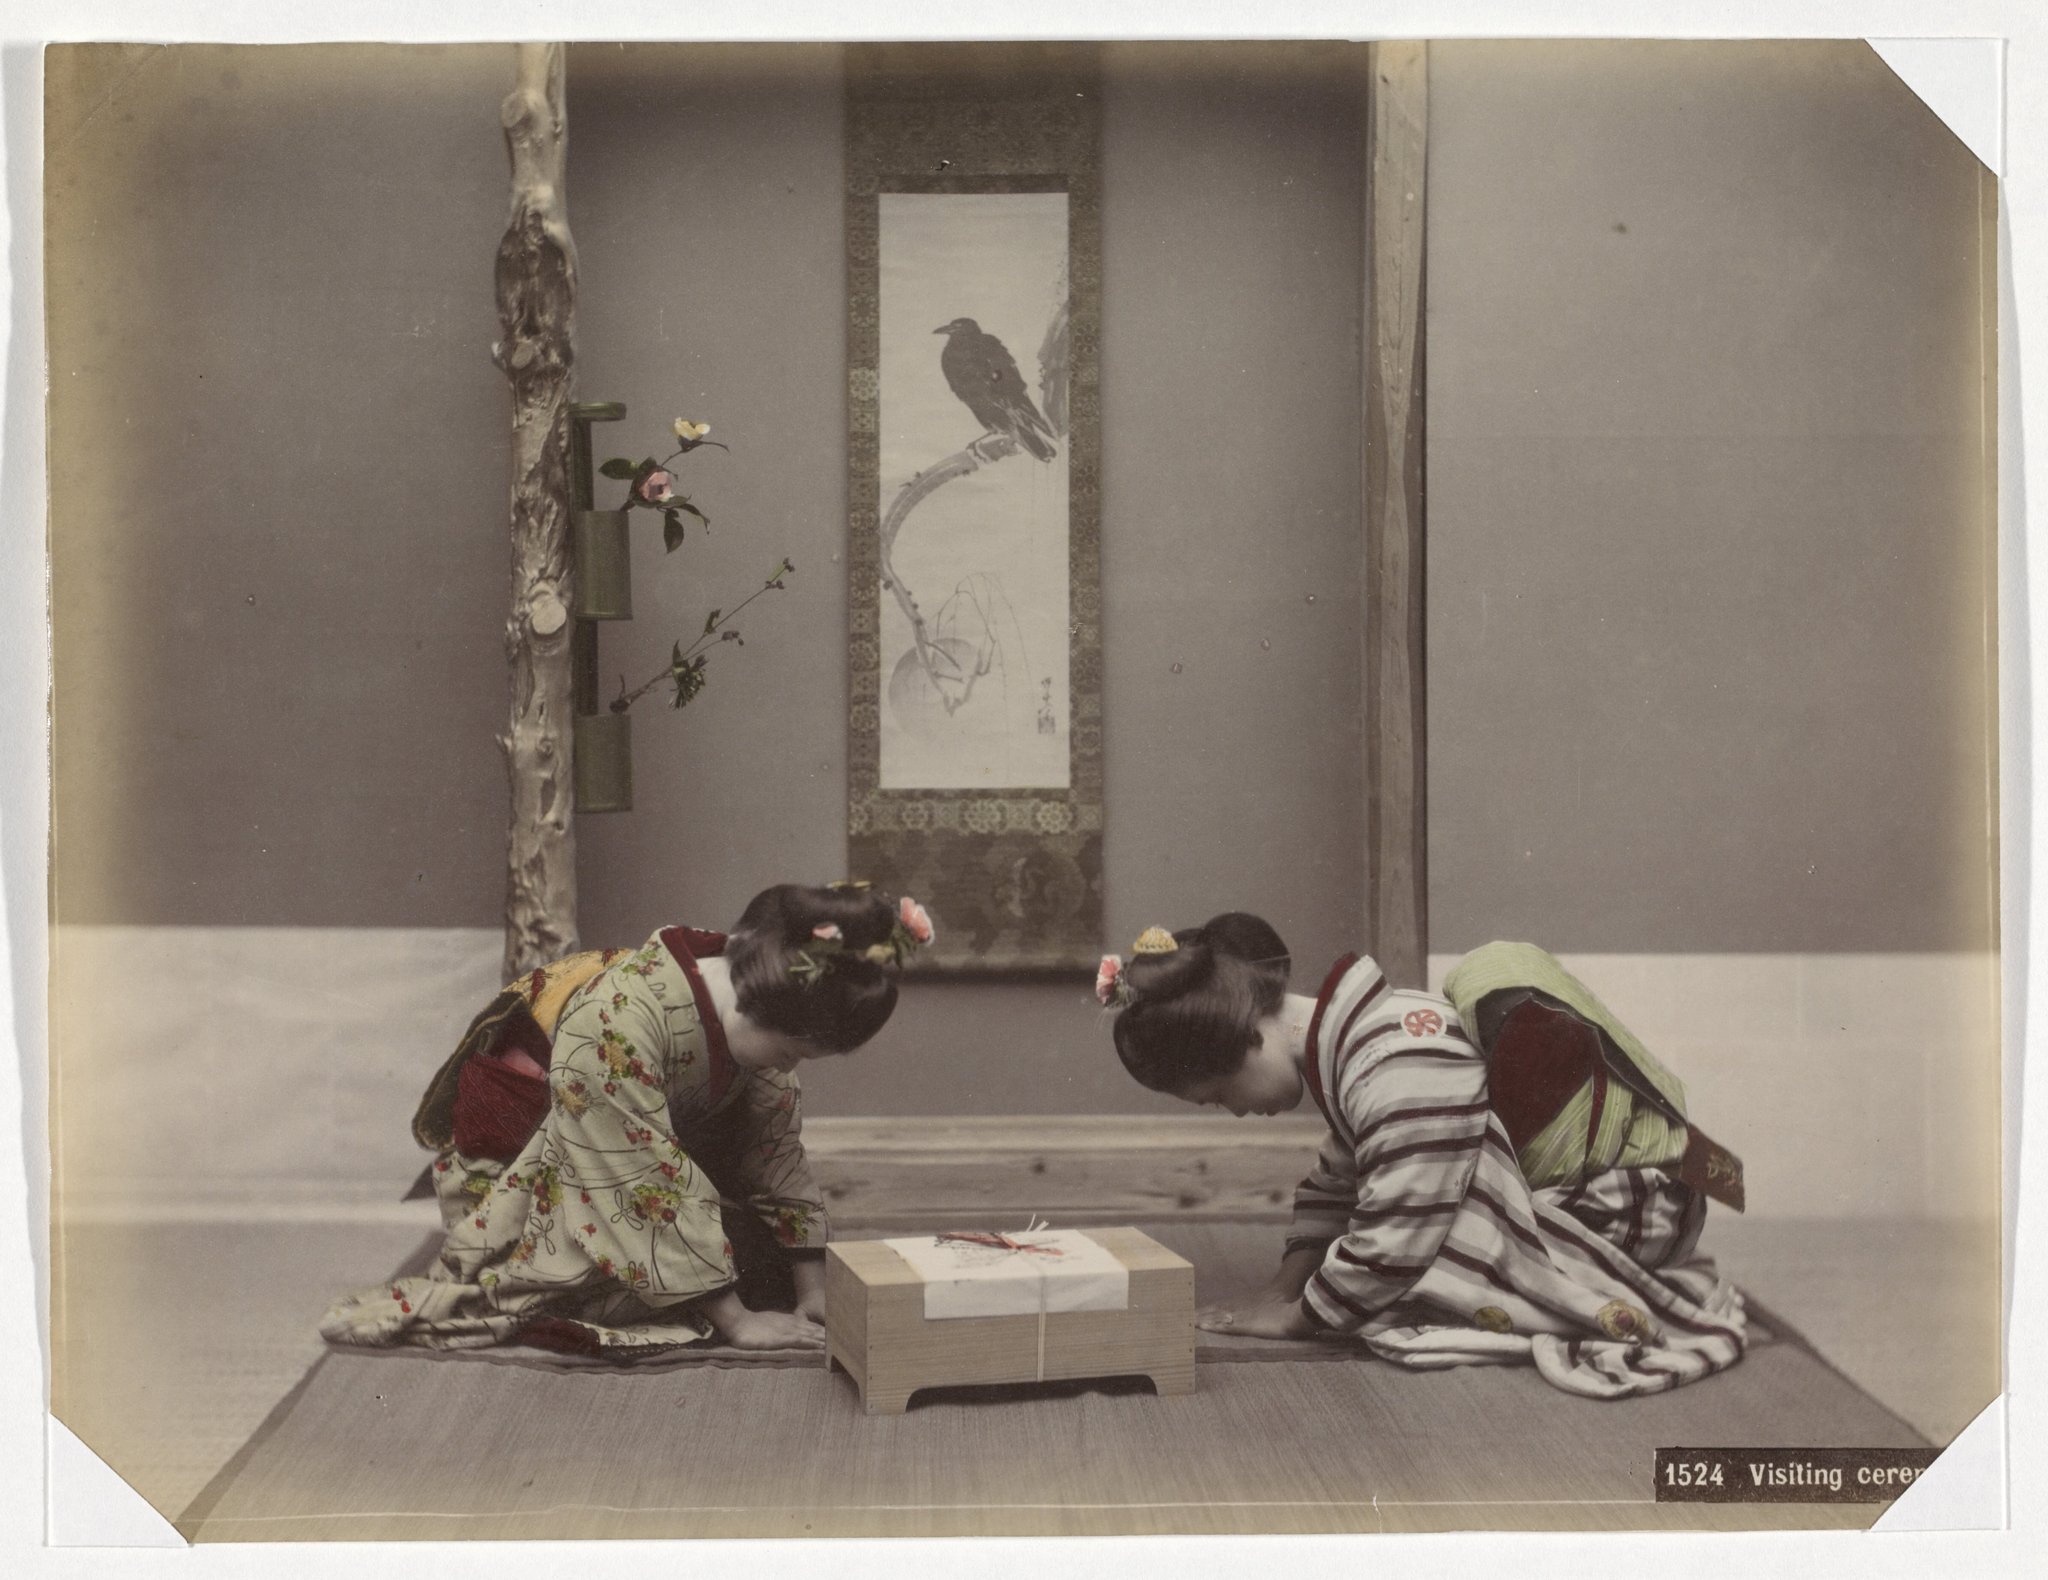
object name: photograph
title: Begroetingsritueel van twee Japanse vrouwen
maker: Anonymous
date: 1890-1894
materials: cardboard, paper, photographic support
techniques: albumen print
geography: japan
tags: ritual practices with particular objectives ~ hinduism, buddhism, jainism, japan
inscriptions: negative number: ‘1524’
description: Onderdeel van Album met 69 foto's van een reis door Japan.